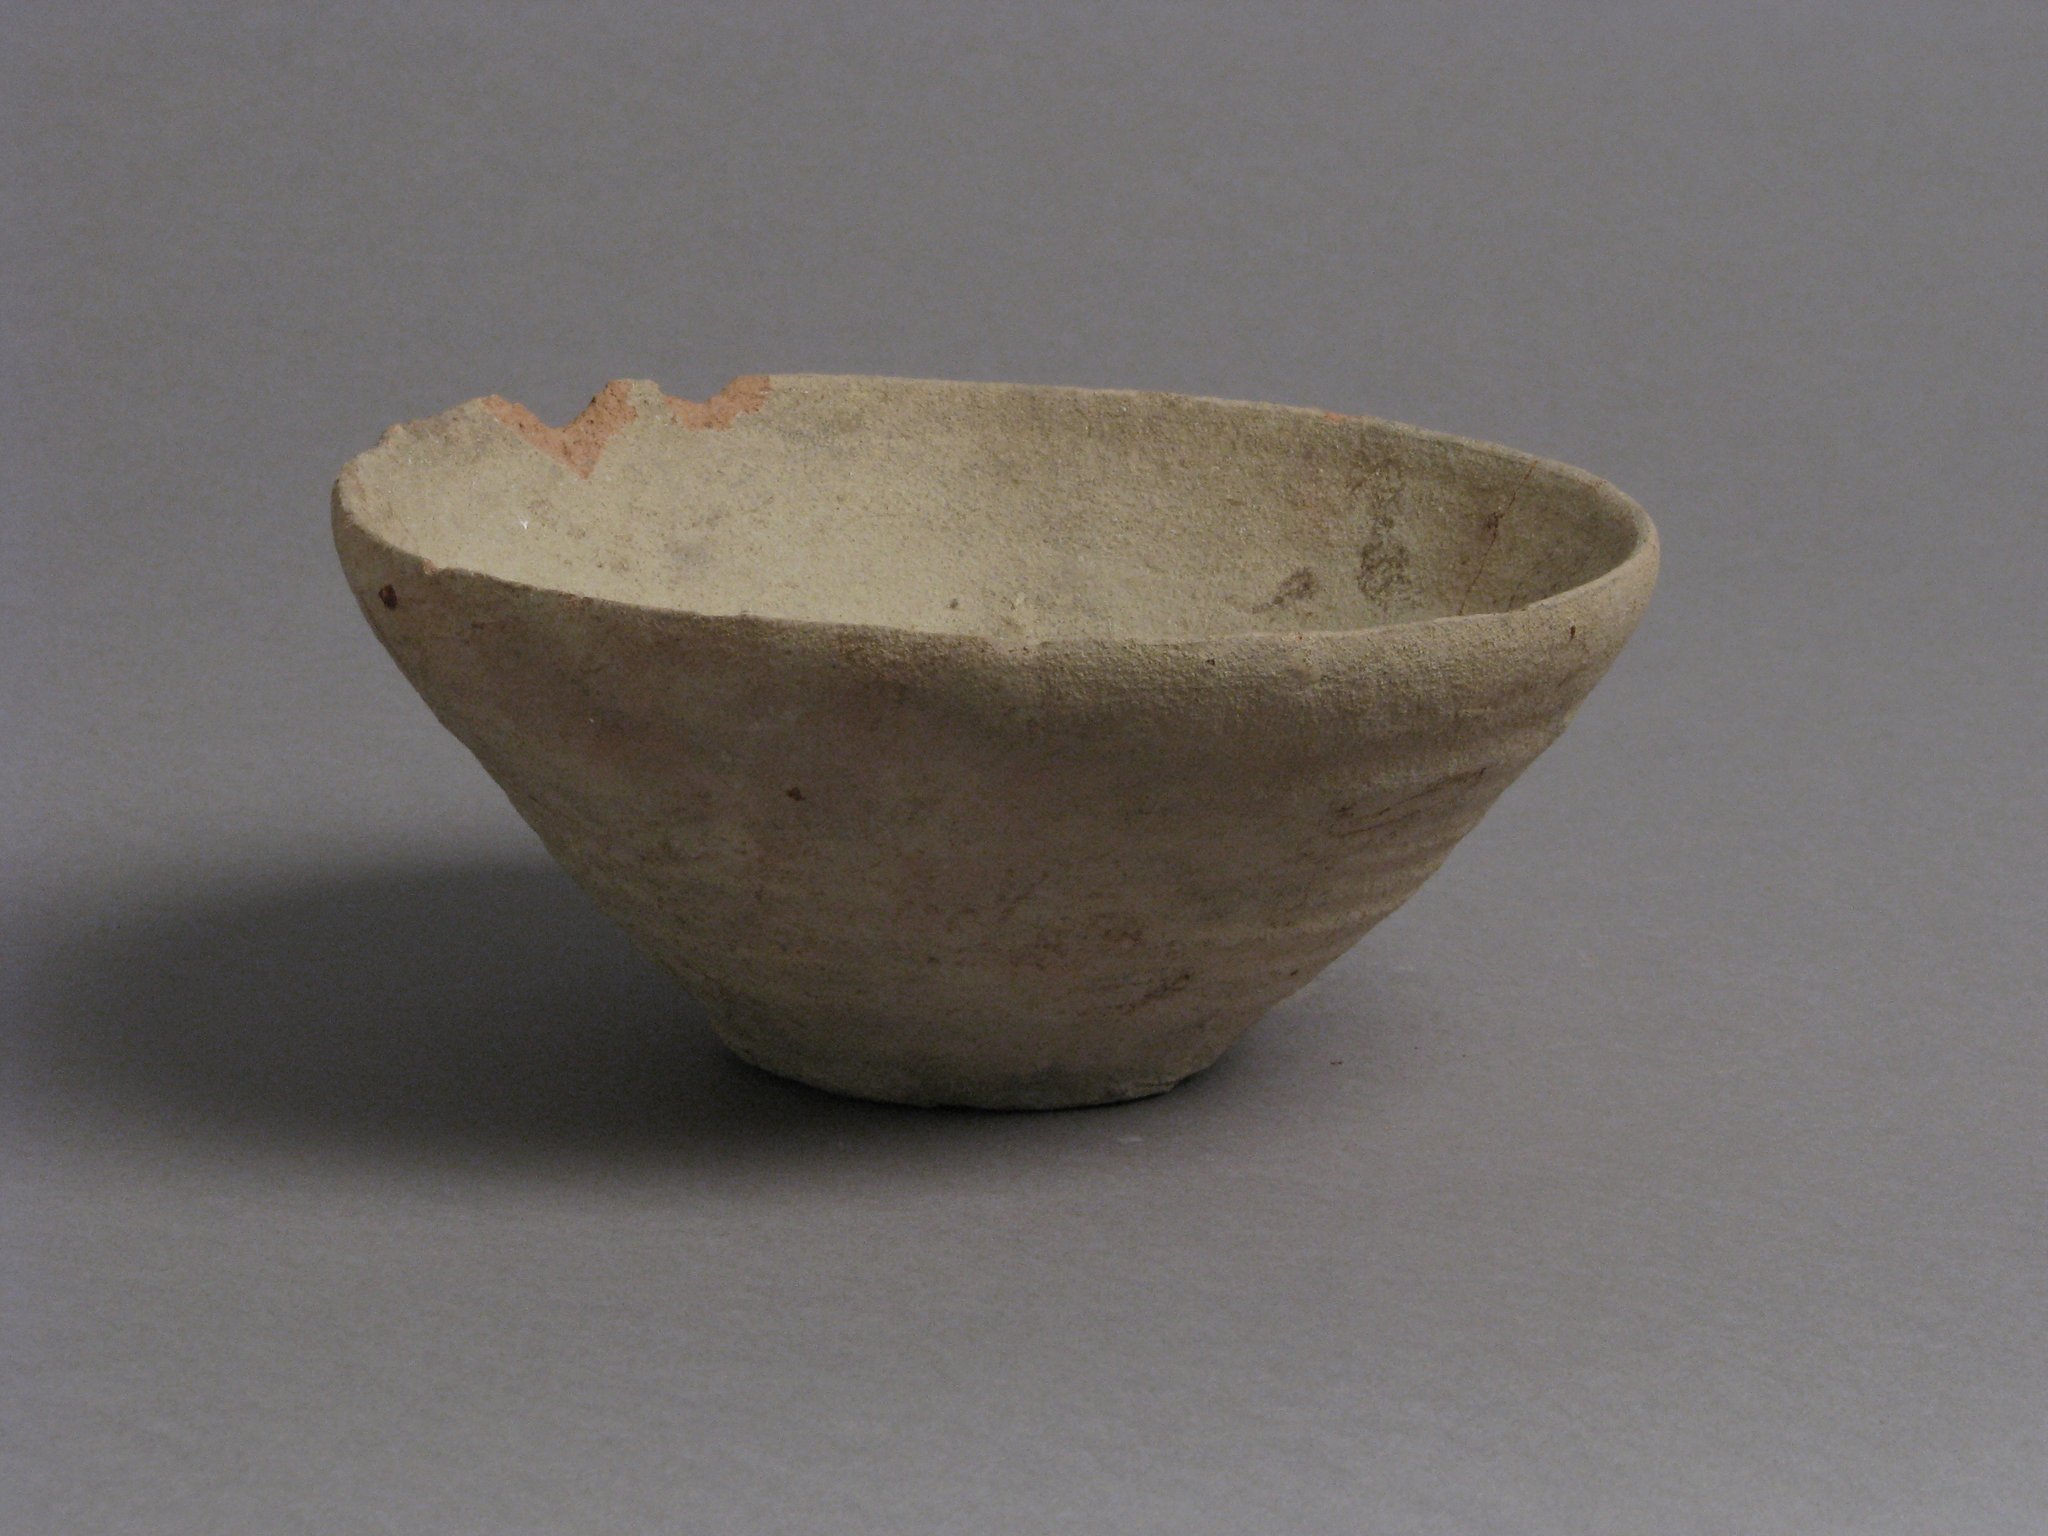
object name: bowl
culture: coptic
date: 301-700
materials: earthenware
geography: egypt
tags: bowls